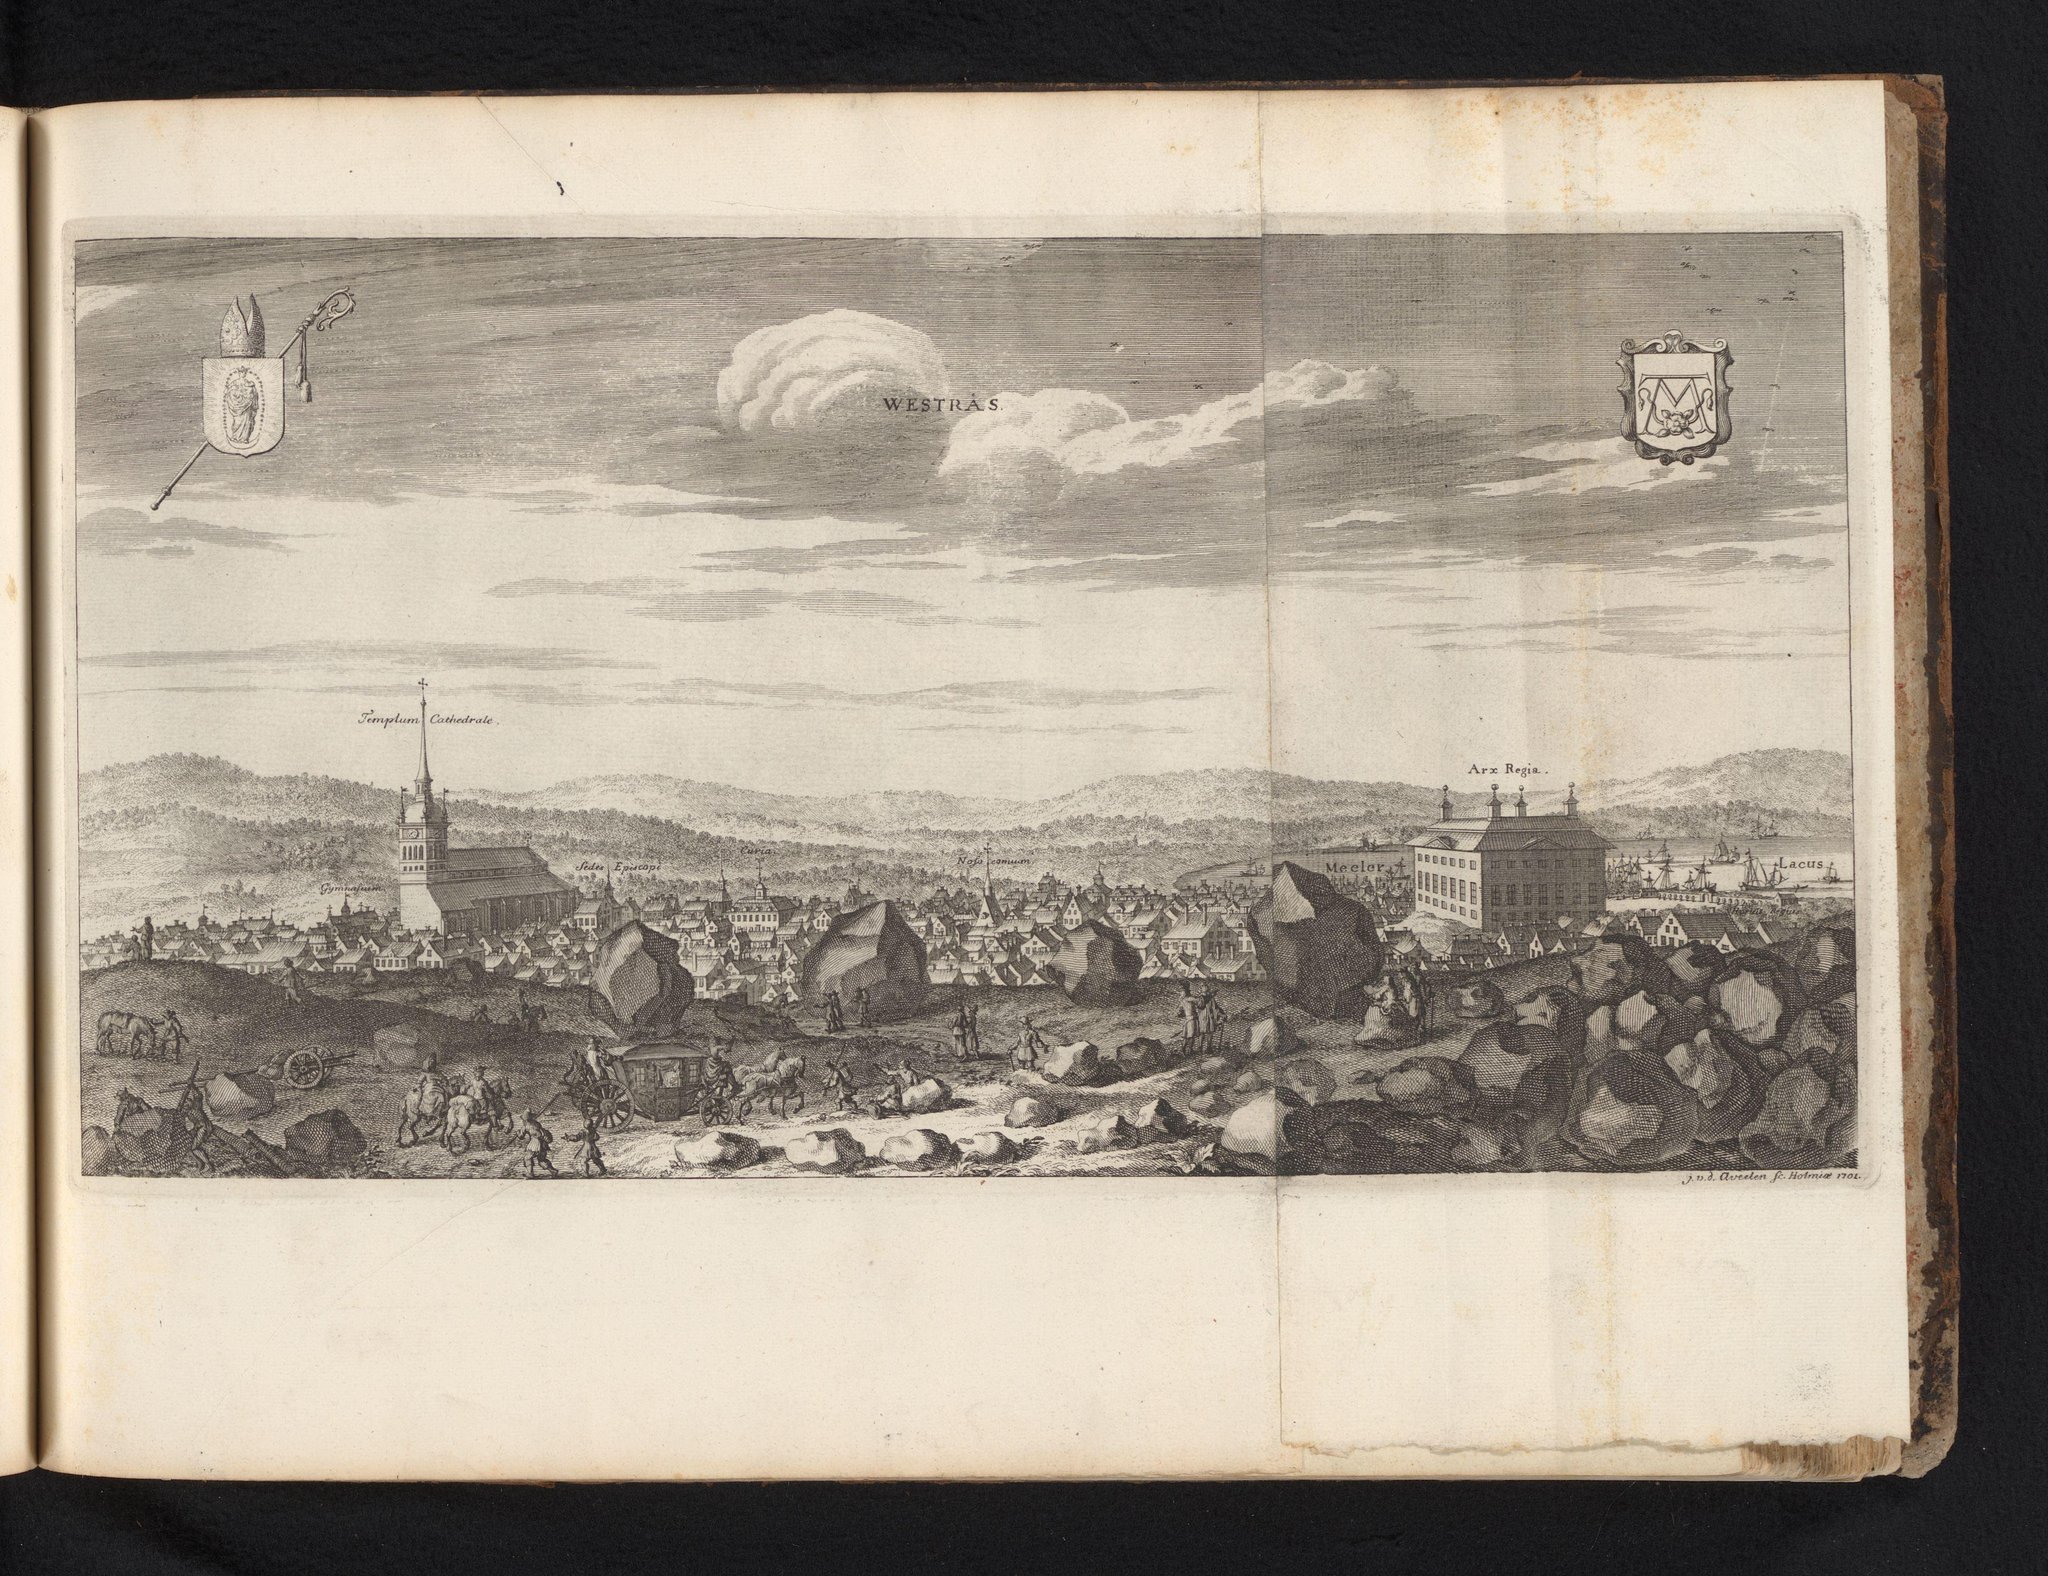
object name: print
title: Gezicht op Västerås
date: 1701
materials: paper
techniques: etching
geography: stockholm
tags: city-view in general; 'veduta'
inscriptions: date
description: Kungliga Biblioteket, 'Suecia': http://www.kb.se/samlingarna/Kartor-bilder/Suecia-antiqua/ (geraadpleegd november 2016).